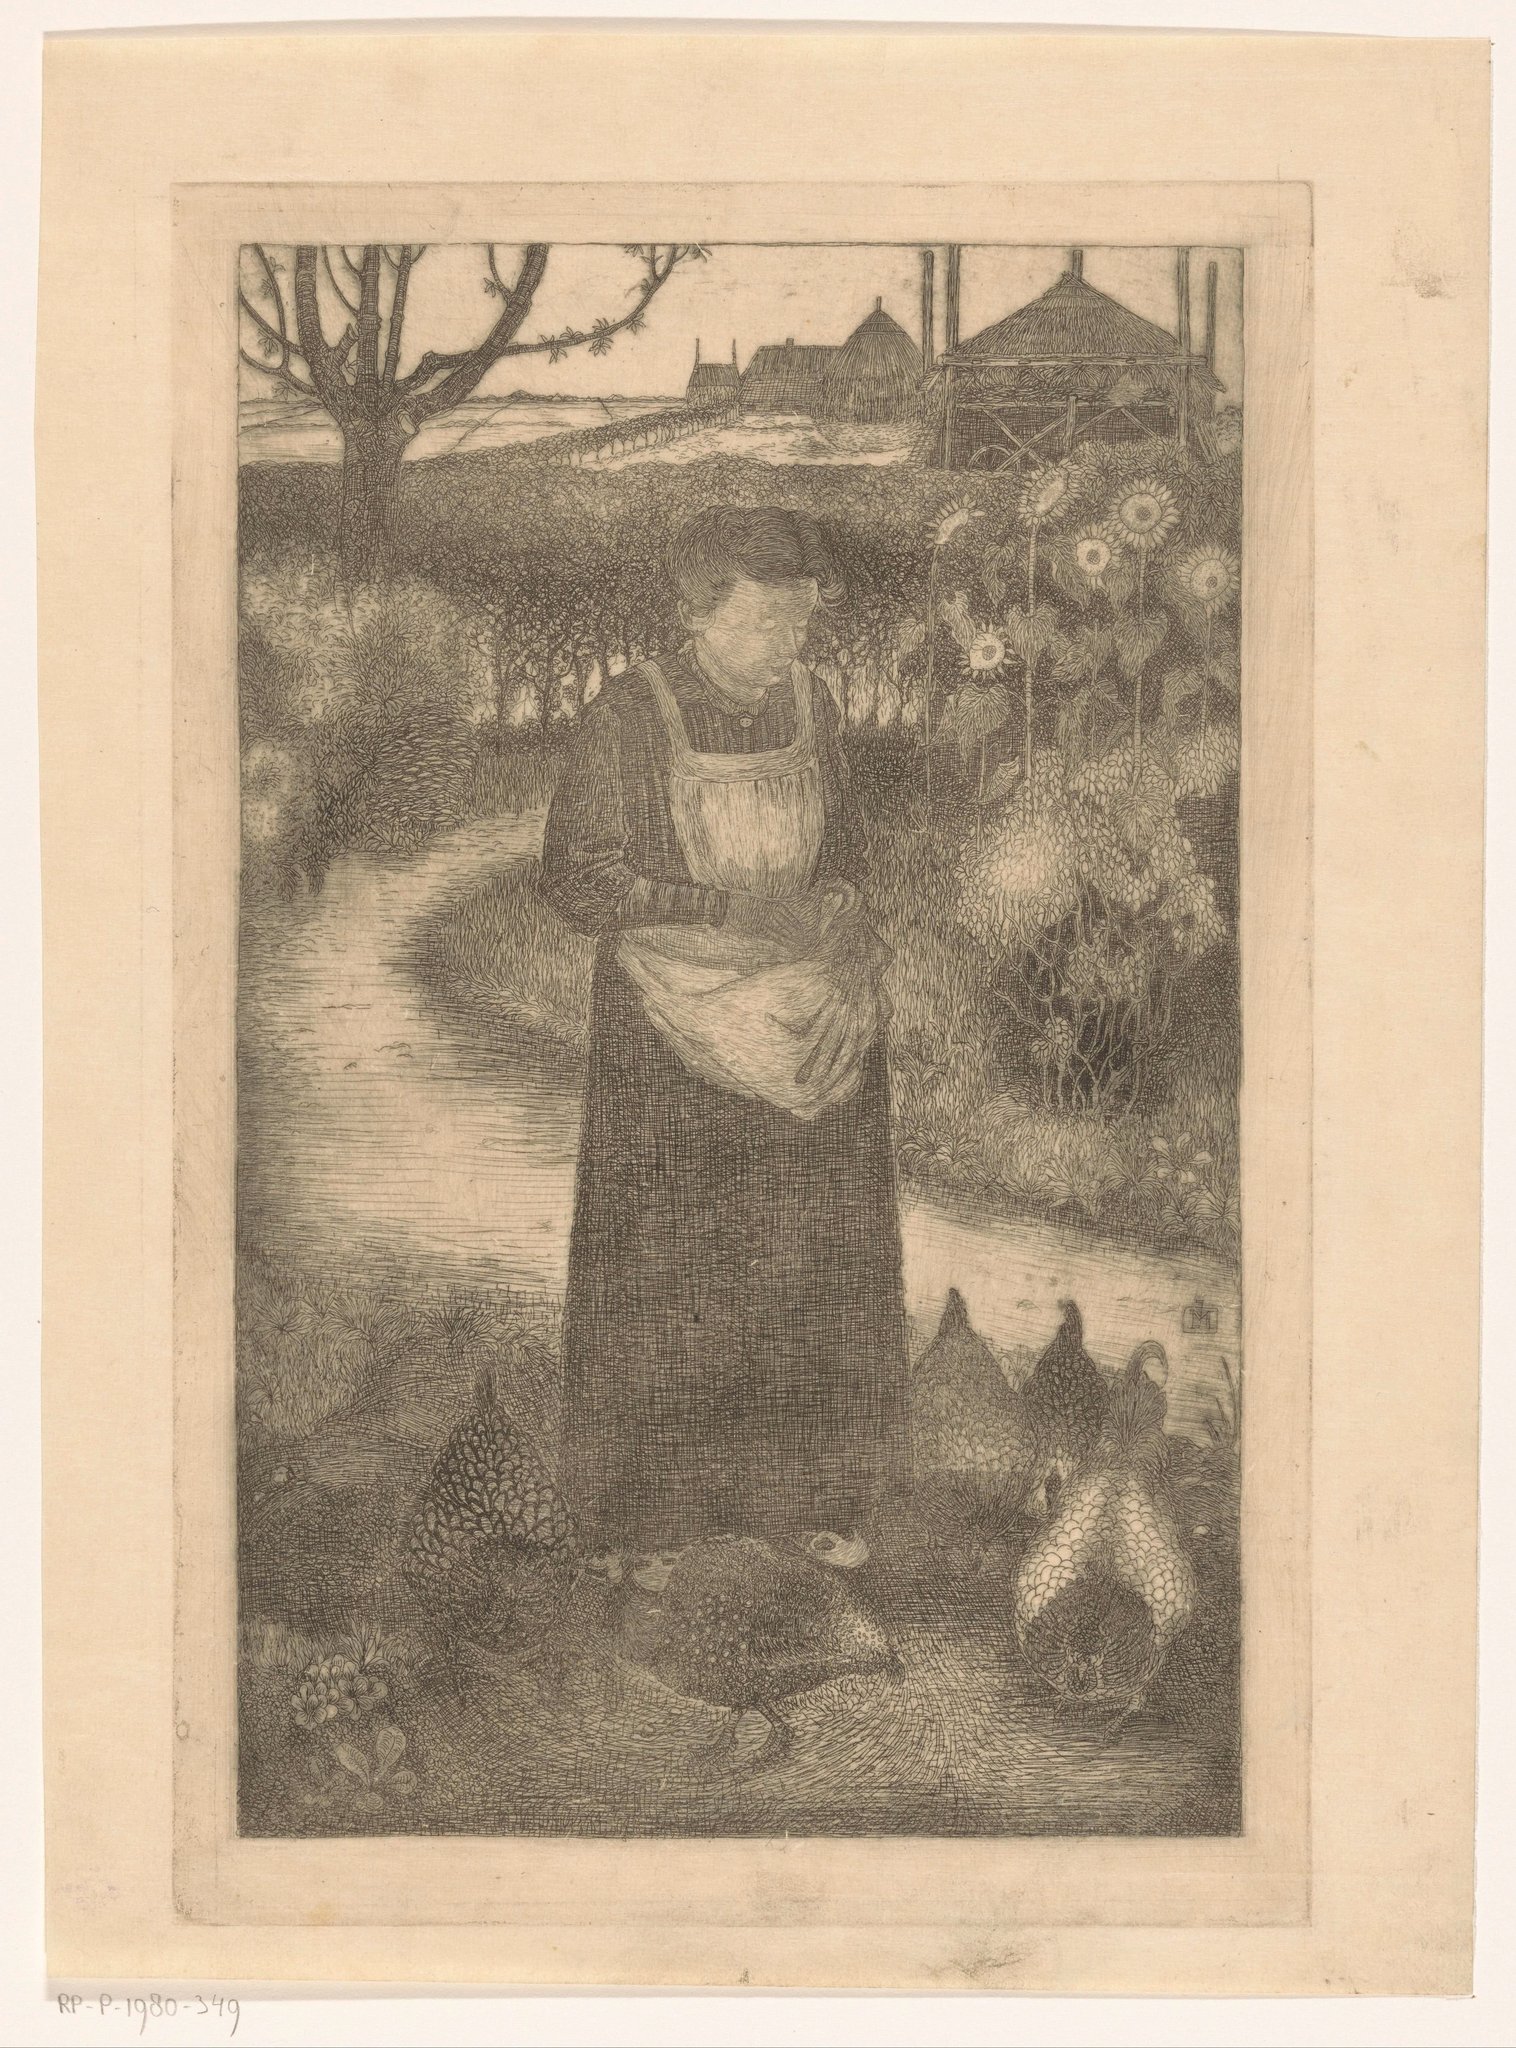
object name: print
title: Anne Zernike voert de kippen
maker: jan mankes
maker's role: draughtsman, painter, print maker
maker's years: 1889-1920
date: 1917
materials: paper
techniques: etching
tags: amsterdam, anne mankes-zernike, giving food, flowers: sunflower, fowl (cock, hen, chicken, etc.), hay-stack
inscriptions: collector's mark: Lugt 2228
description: Op de achtergrond een veld met zonnebloemen en een hooimijt.